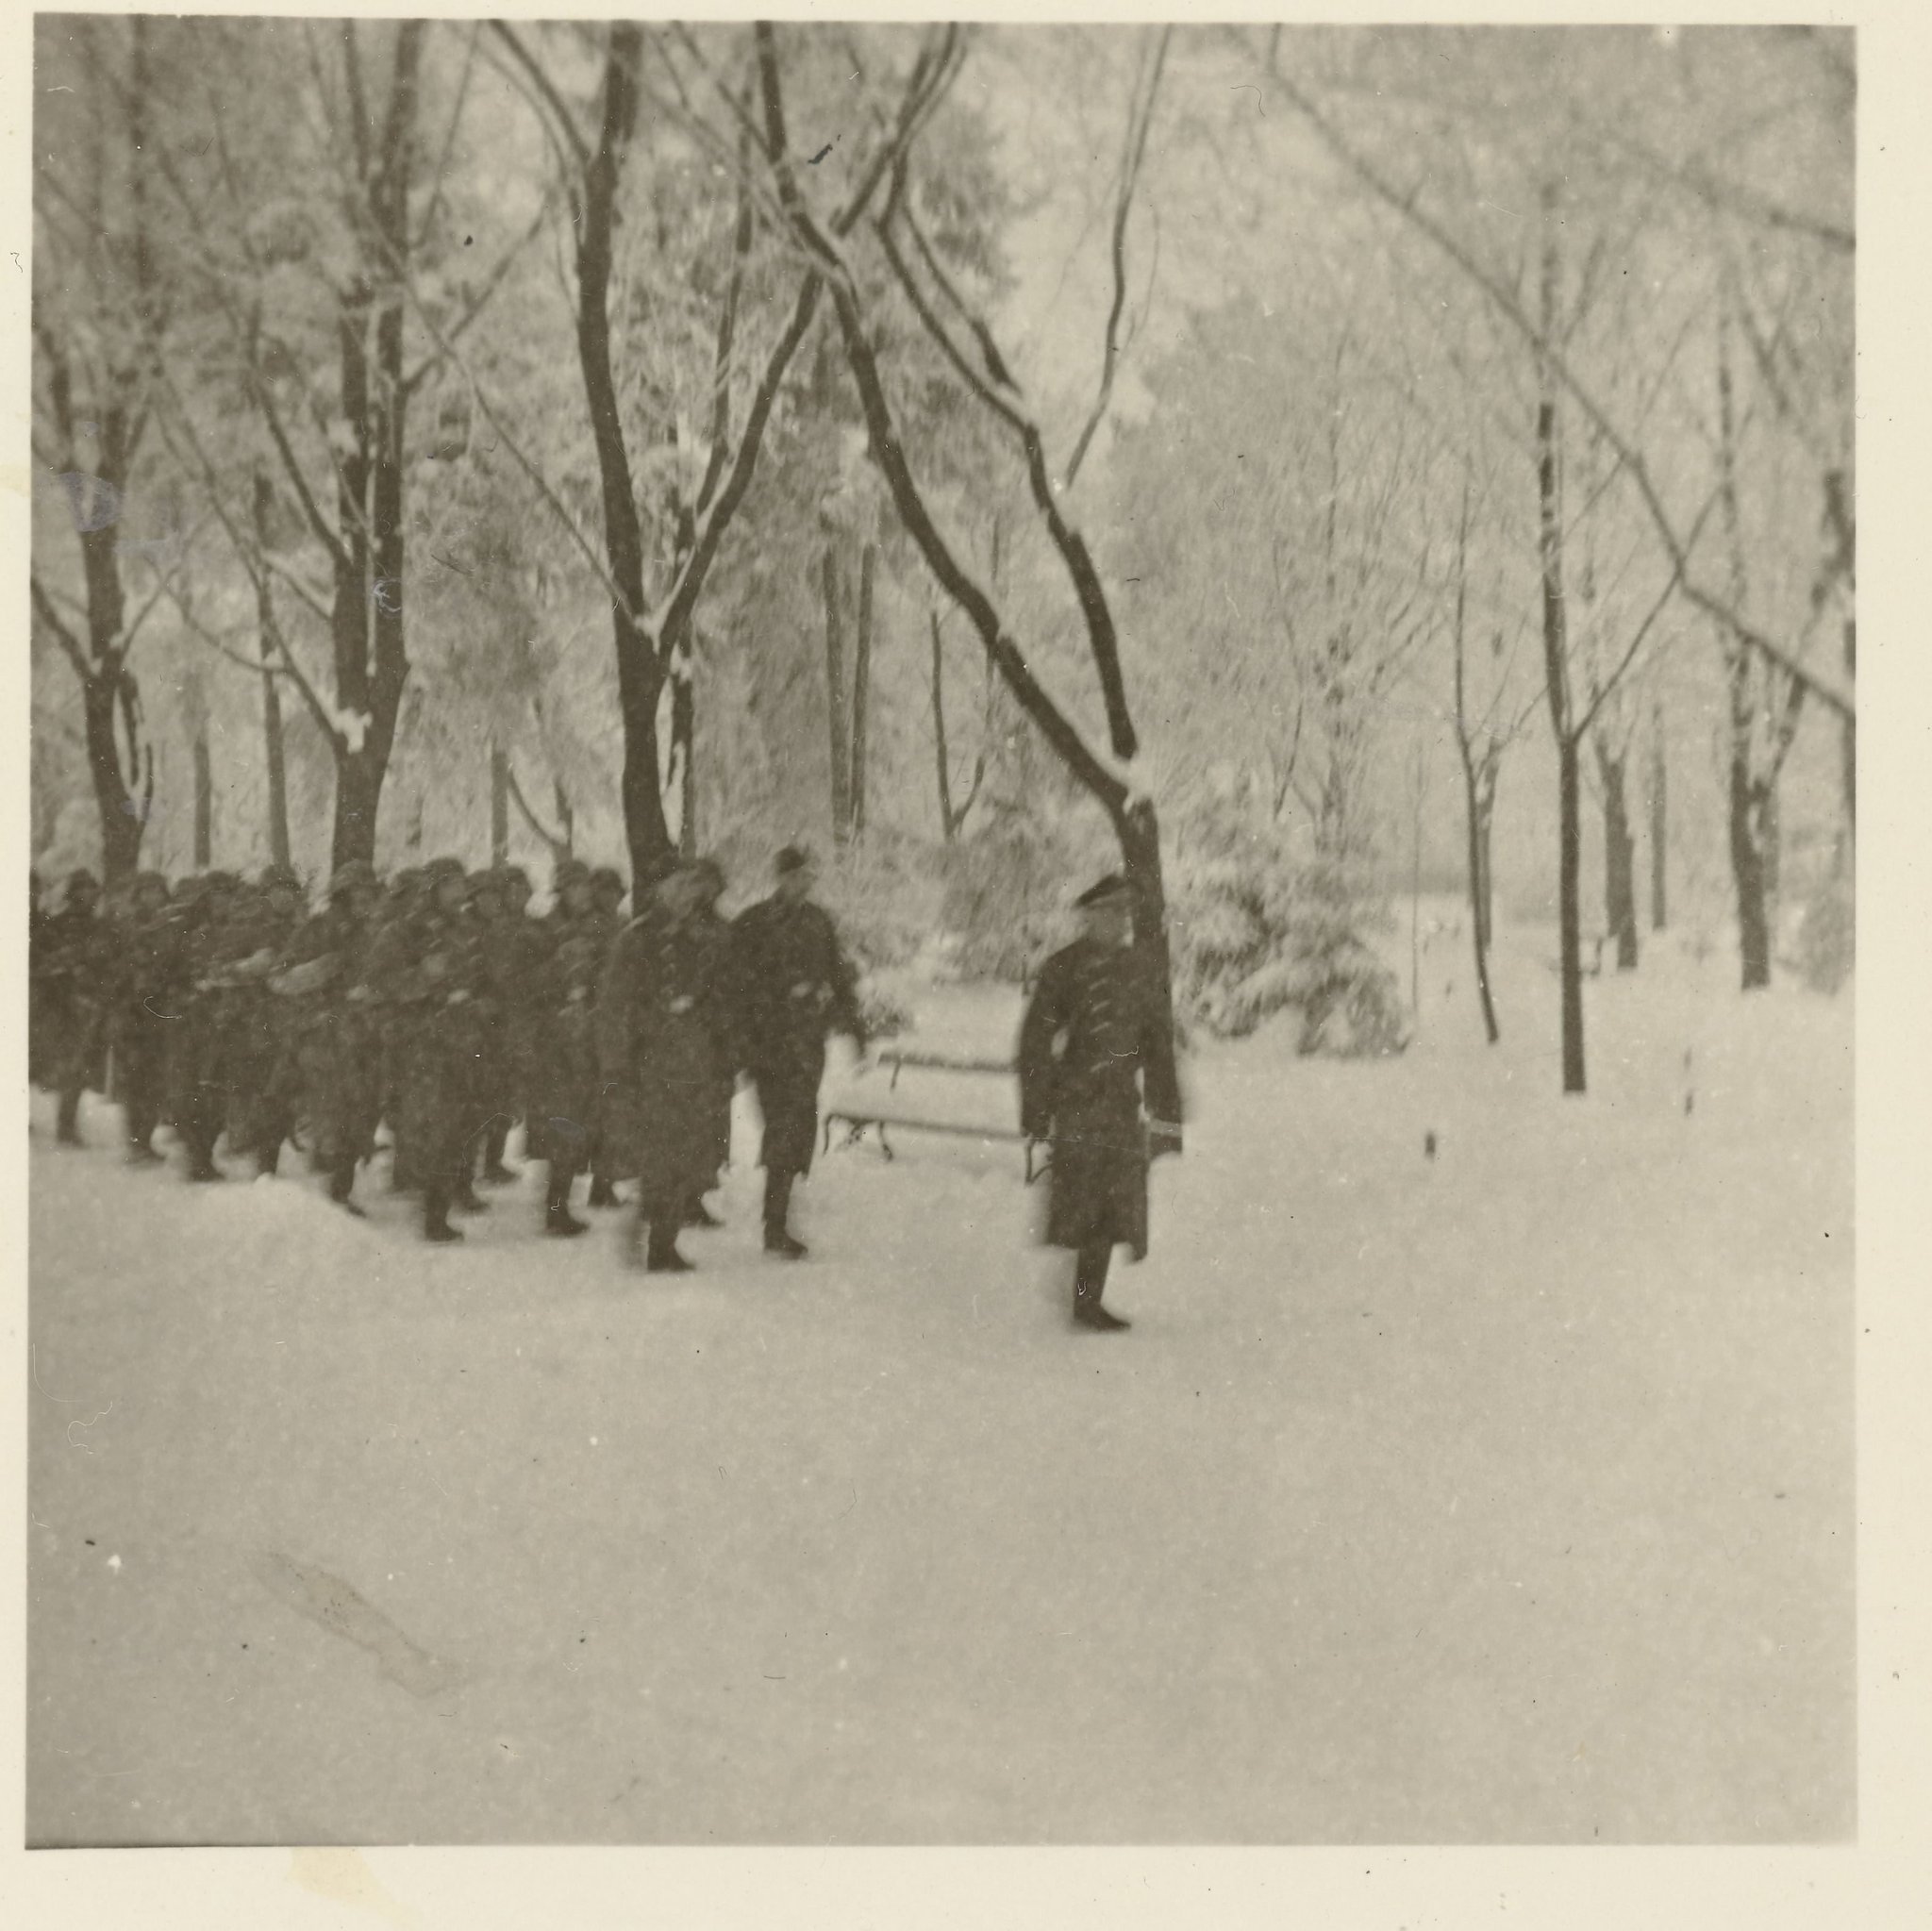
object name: photograph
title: Wehrmachtsoldaten in besneeuwd bos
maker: Anonymous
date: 1940-1945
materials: photographic support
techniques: gelatin silver print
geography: czechoslovakia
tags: germany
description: Een groep Wehrmachtsoldaten loopt door een besneeuwd bos. Foto behorend bij album 'Kriegserinnerungen'.